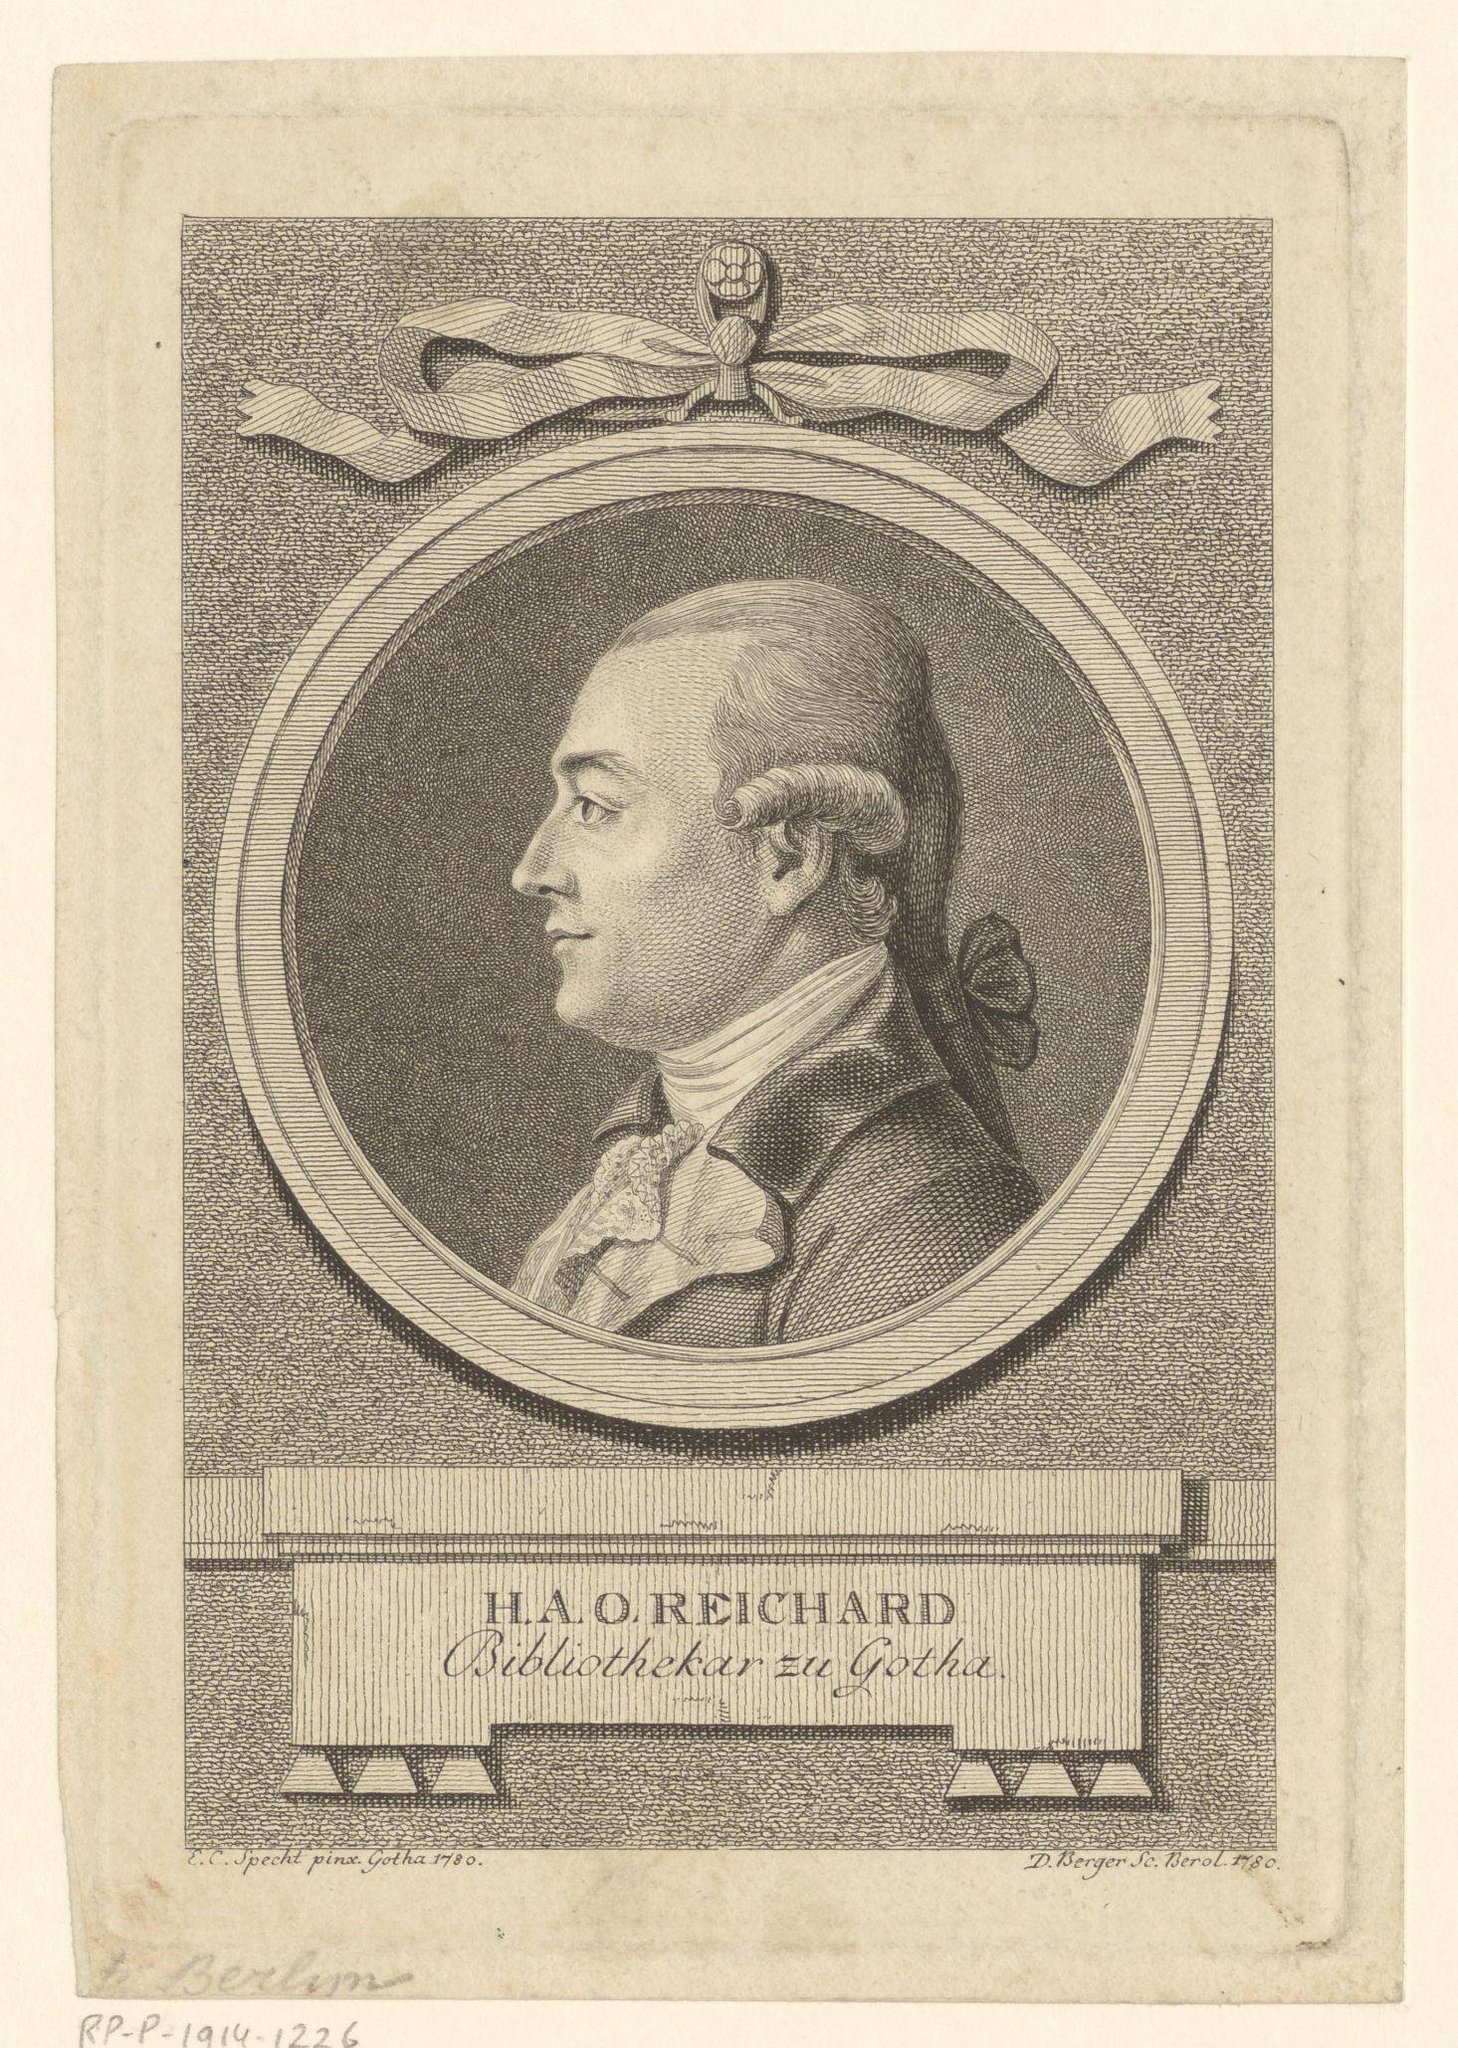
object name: print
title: Portret van Heinrich August Ottokar Reichard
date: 1780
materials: paper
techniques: engraving, etching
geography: gotha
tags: historical persons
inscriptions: collector's mark: Lugt 2228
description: Prent ook gebruikt in: Litteratur- und Theater-Zeitung. Derde jaargang, vierde deel. Berlijn: Arnold Wever, 1780.